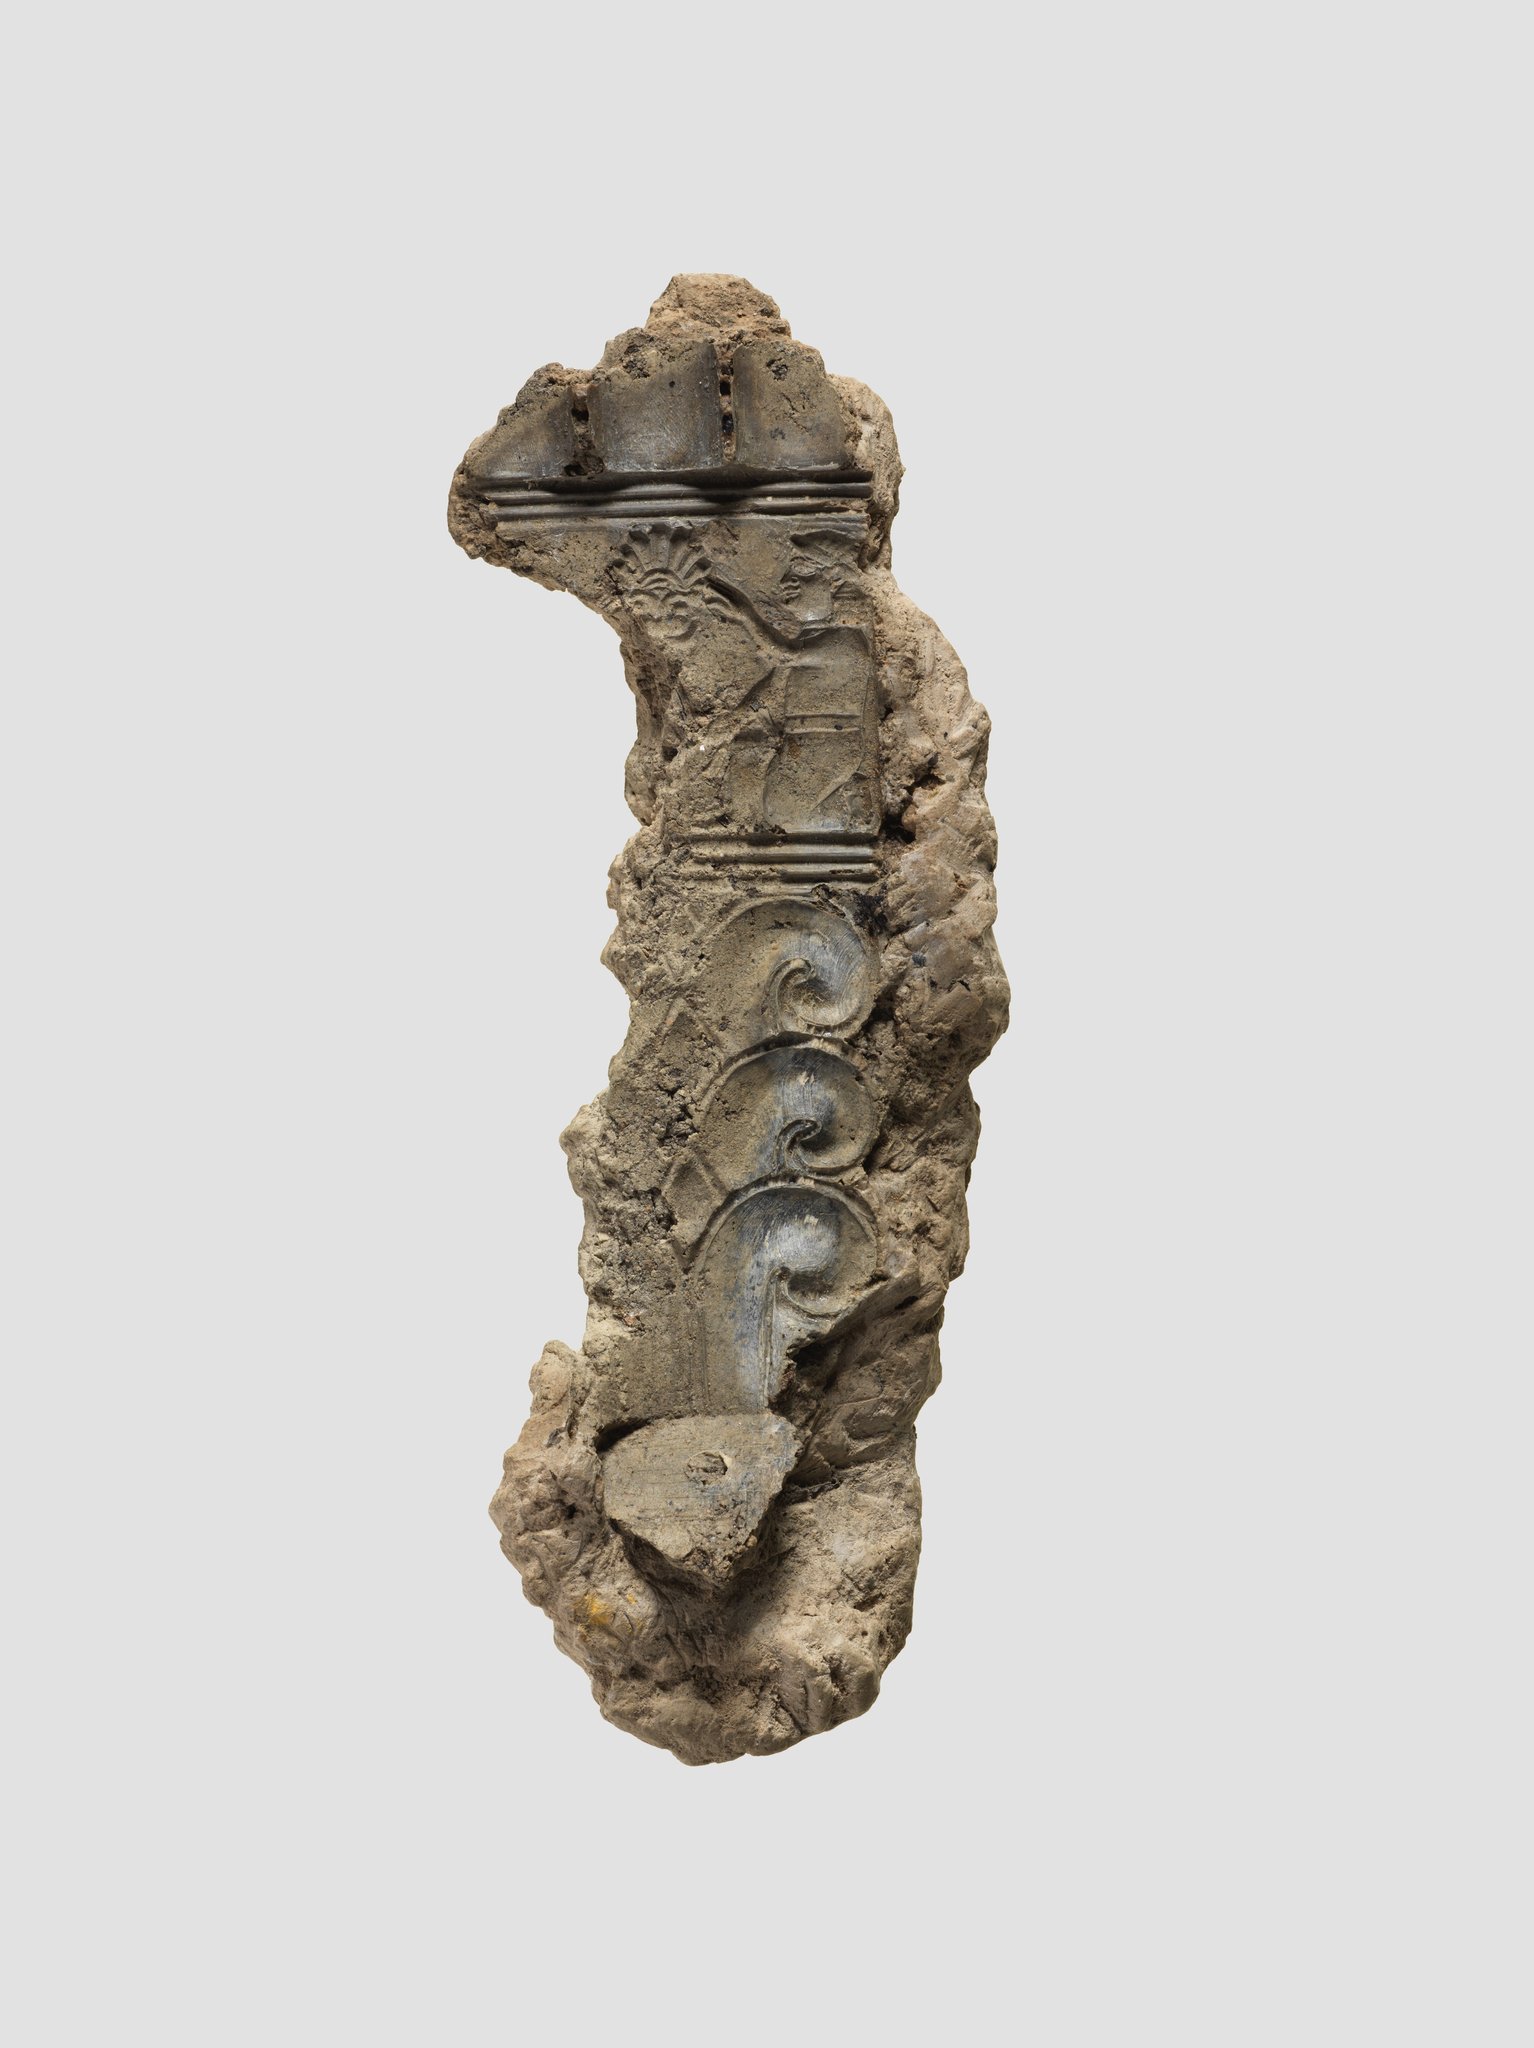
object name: mud impression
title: Mud impression of ivory handle 54.117.3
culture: assyrian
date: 800-701 BCE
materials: mud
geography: mesopotamia